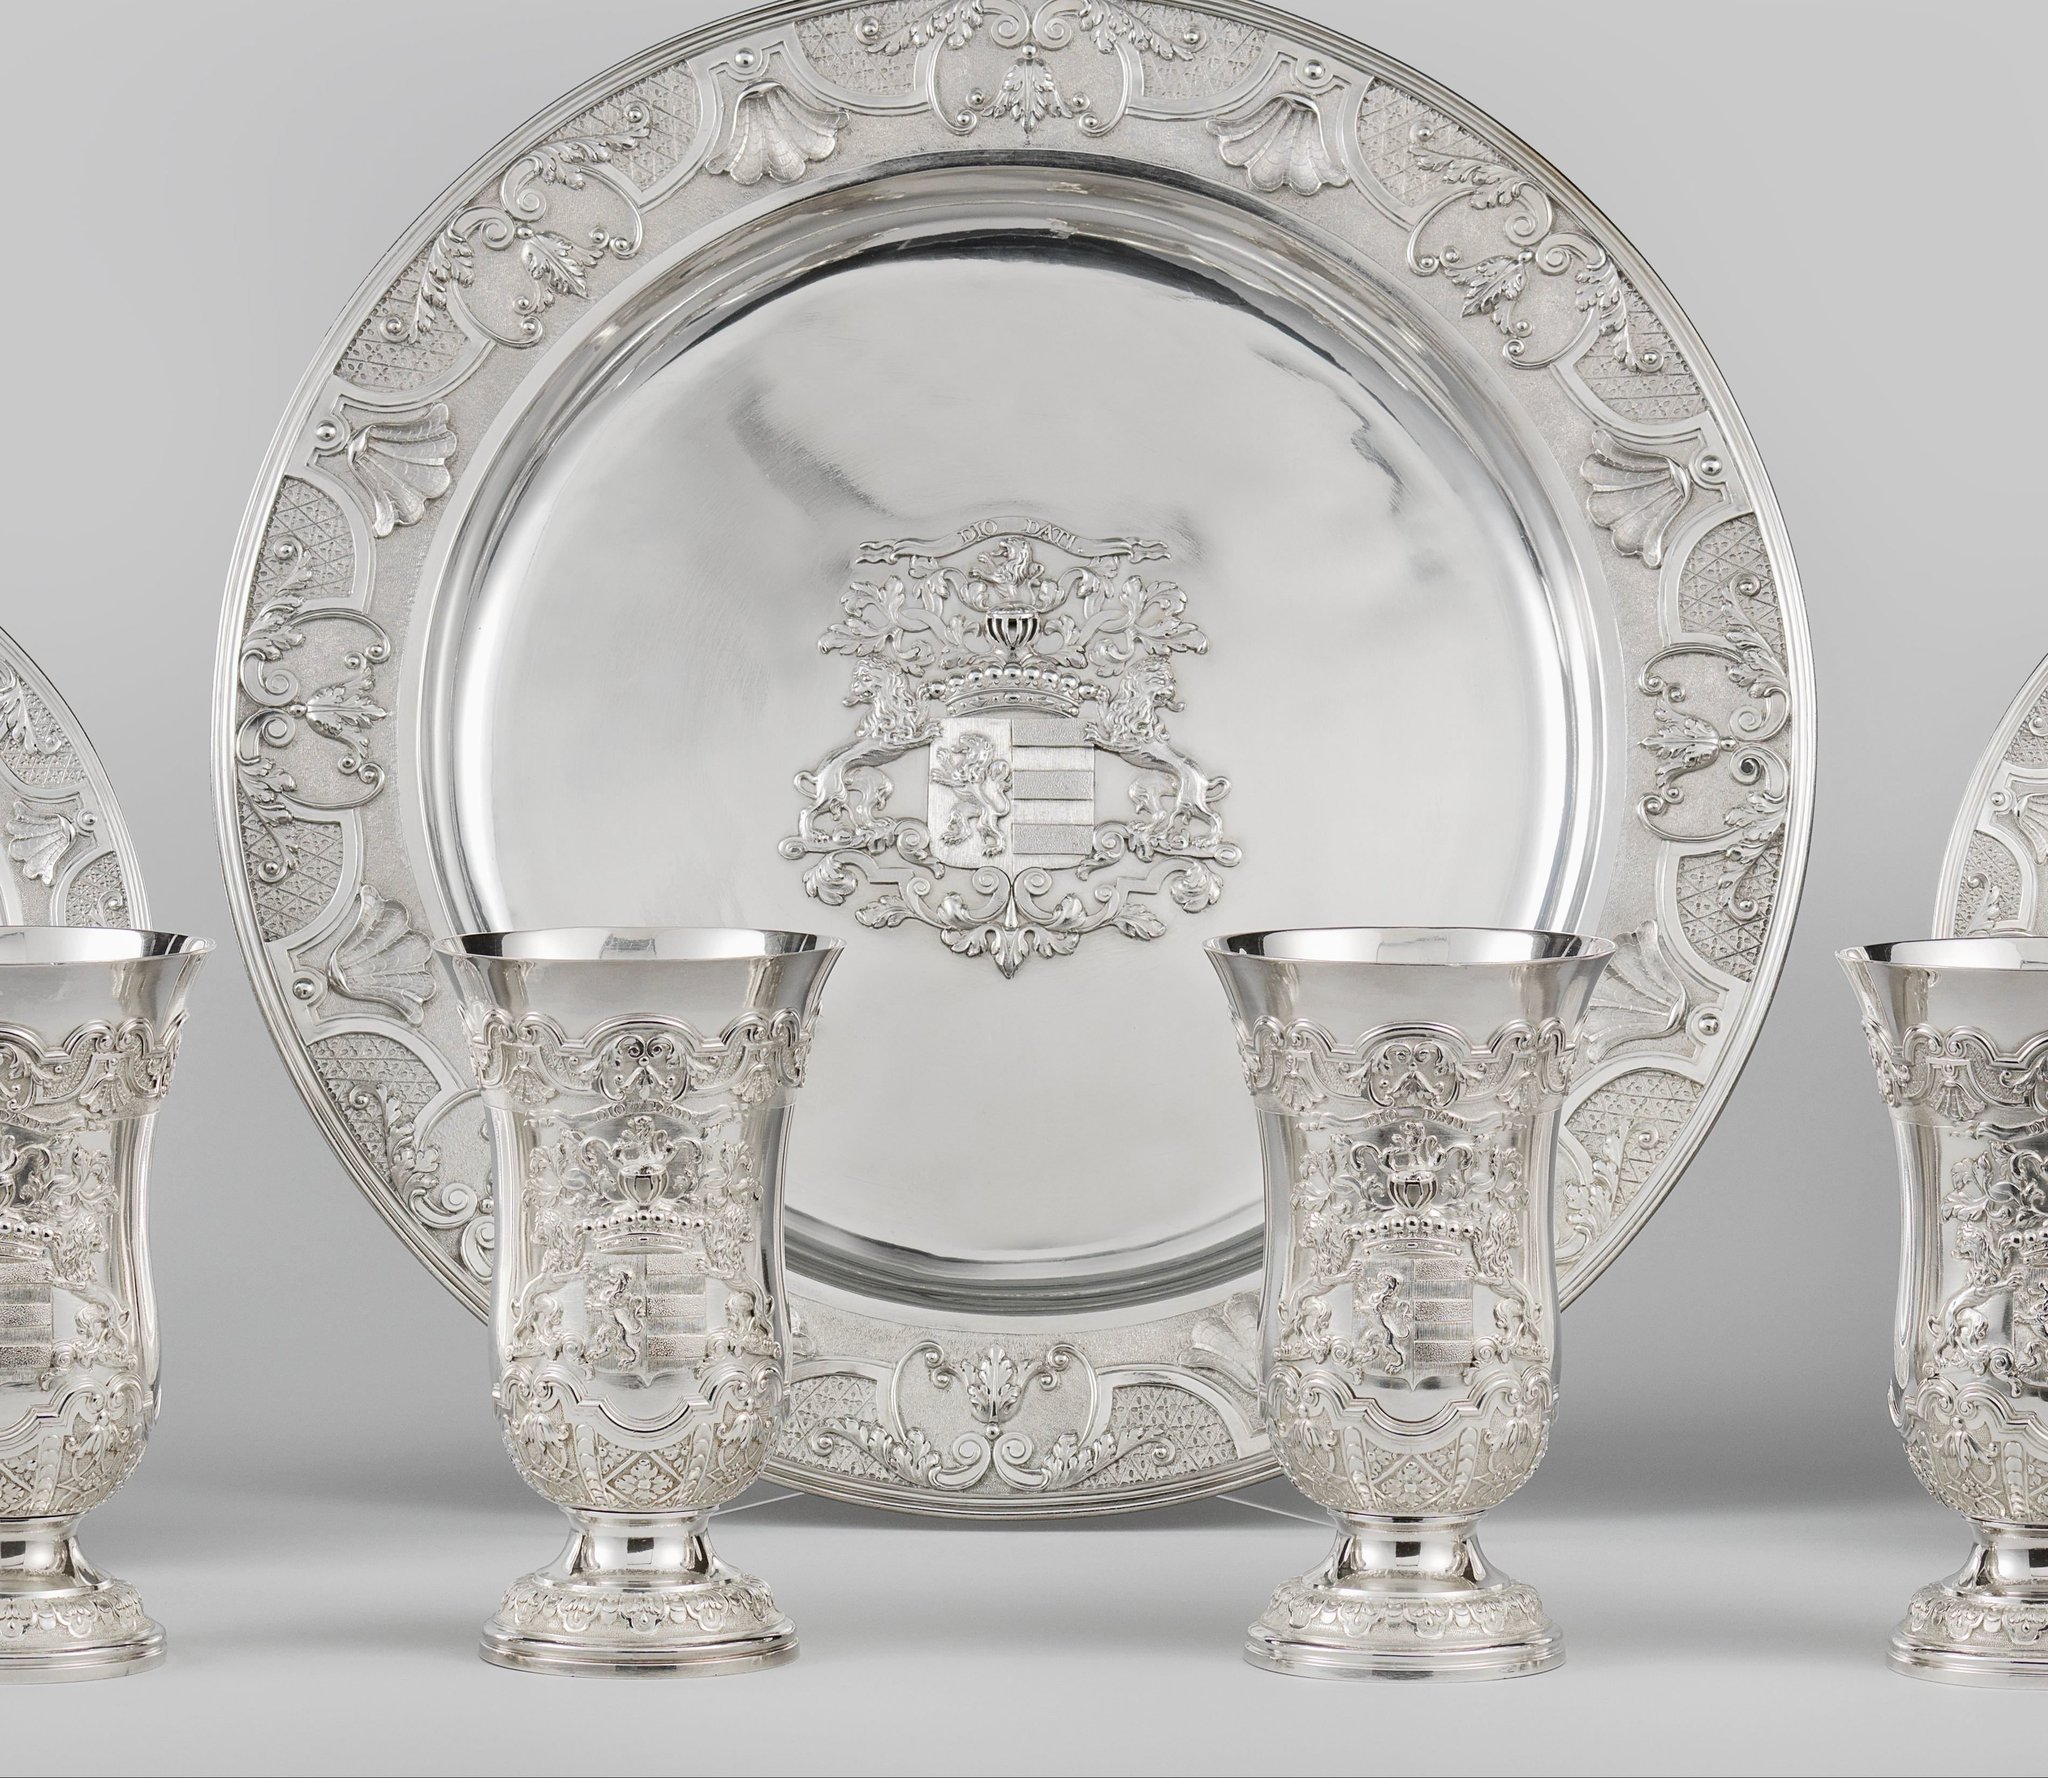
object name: doopstel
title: Avondmaal- en doopstel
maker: dirk wor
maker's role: silversmith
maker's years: 1696-1745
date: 1736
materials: silver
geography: dordrecht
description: Communion and baptism set. Silver. Dordrecht, 1736 and 1746, by Dirk Wor. This set was made for the Nieuwe Kerk in Dordrecht after designs by Aert Schouman and financed from the legacies of Philippe Diodati (d. 1733) and Mattheus Coddaeus (d. 1744). Given by the Commissie voor Fotoverkoop, 1969.